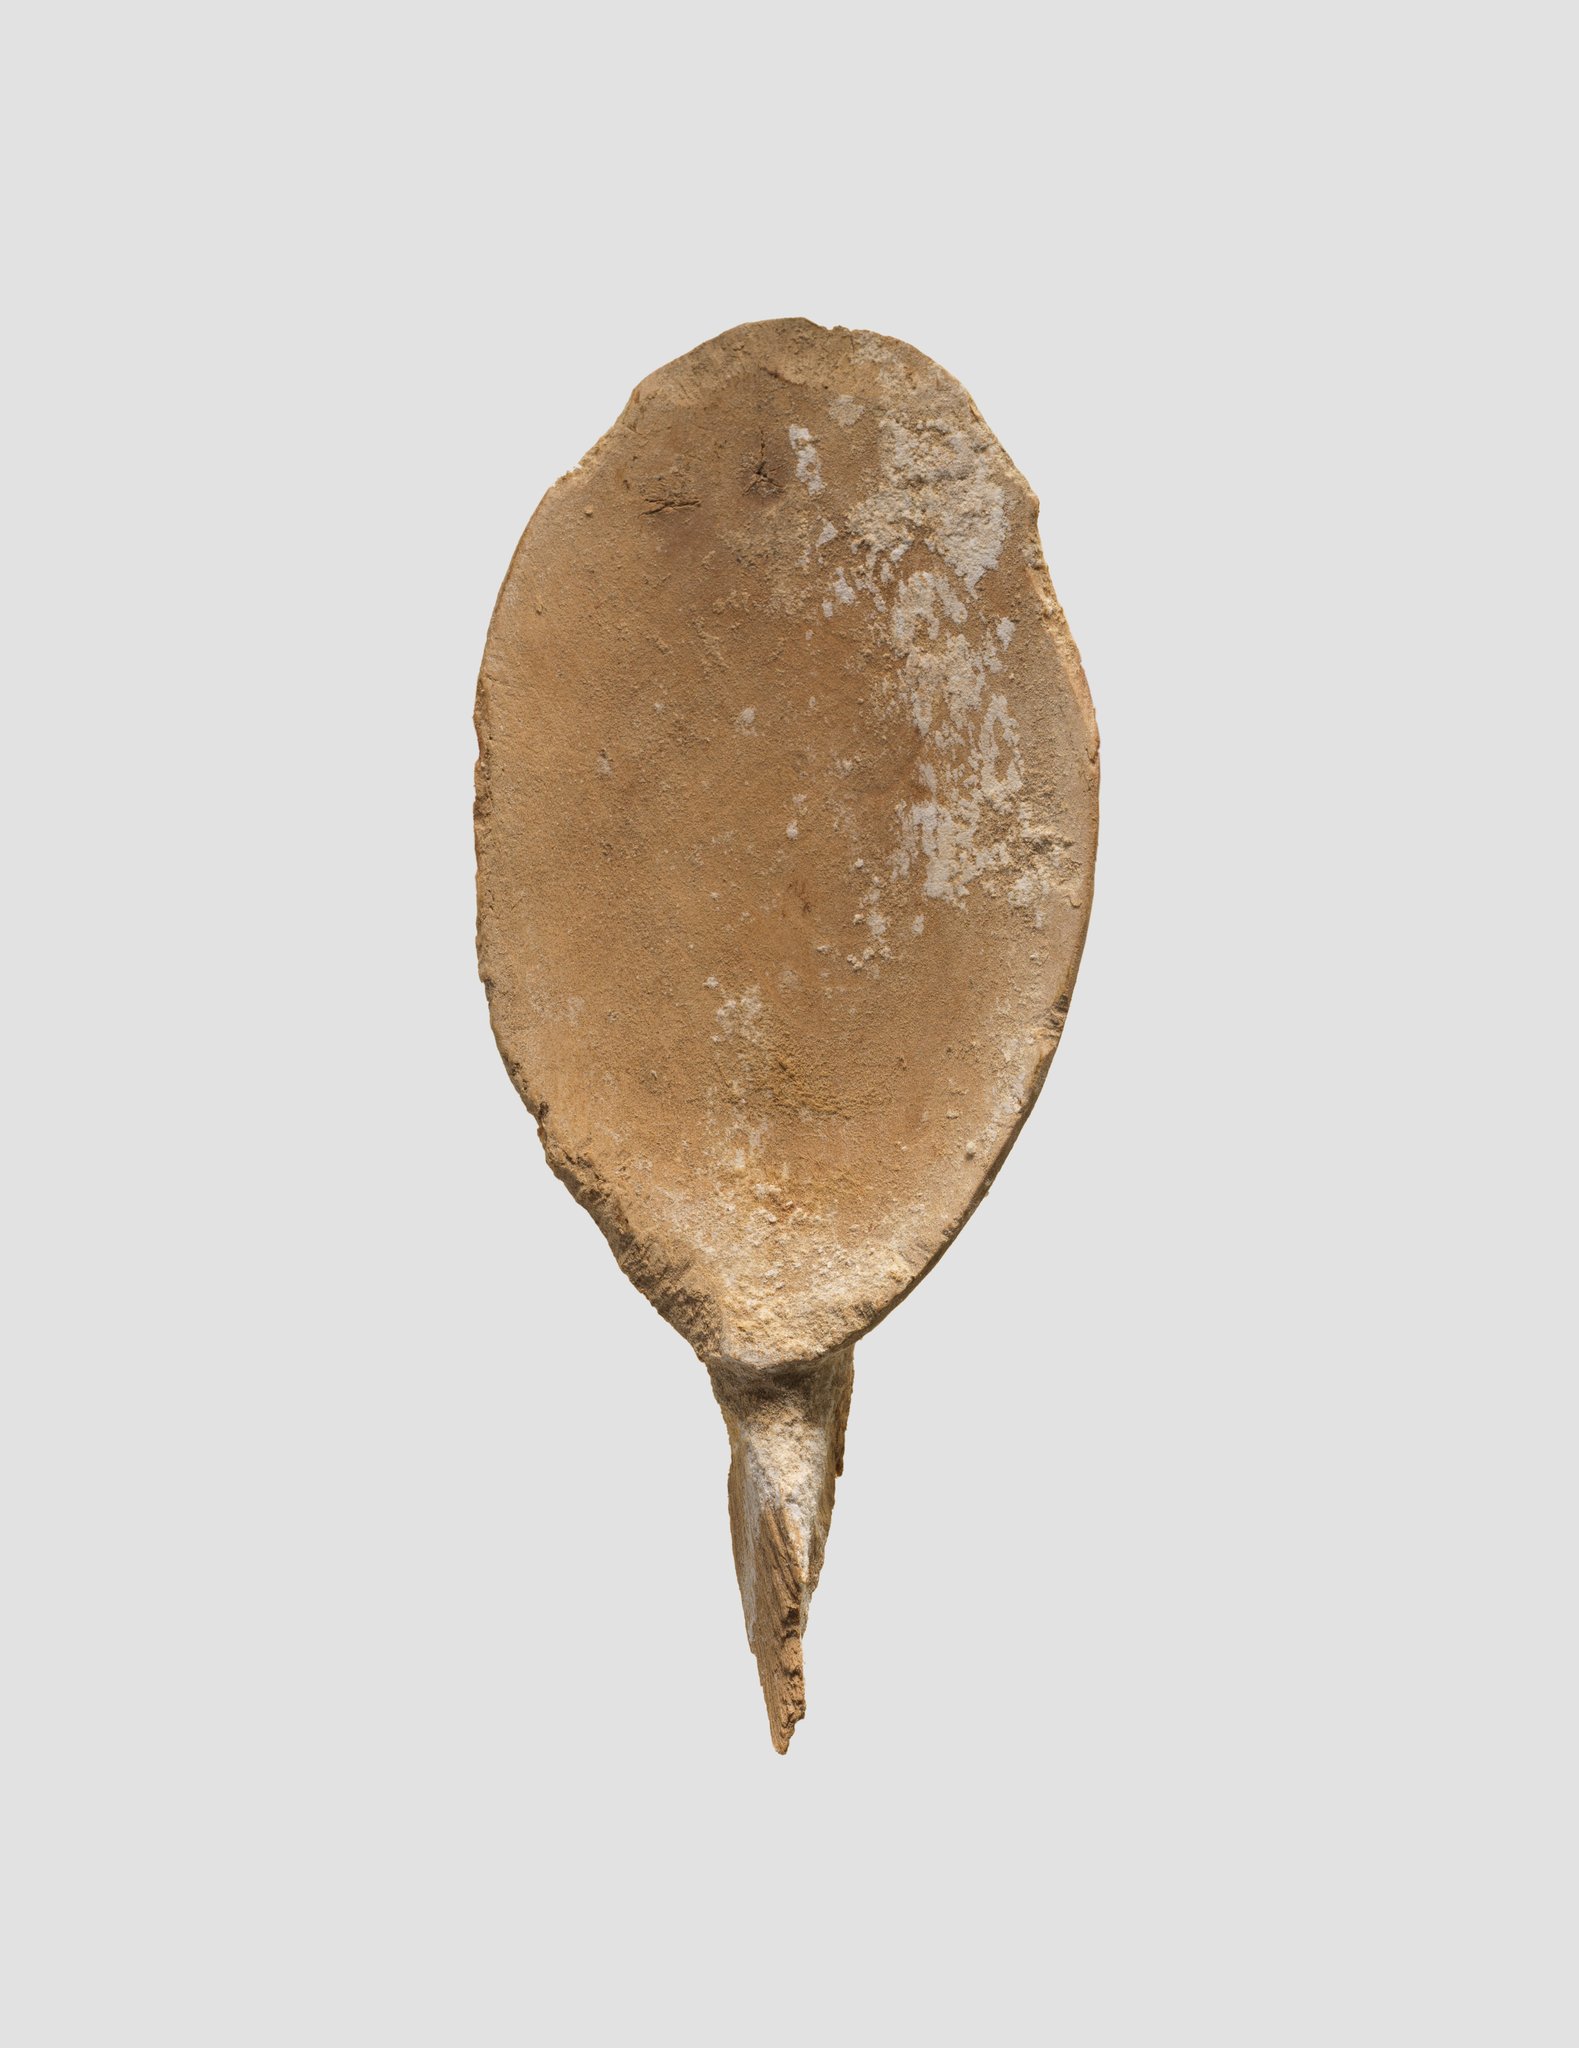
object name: spoon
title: Wooden spoon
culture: alanic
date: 601-900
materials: wood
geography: caucasus